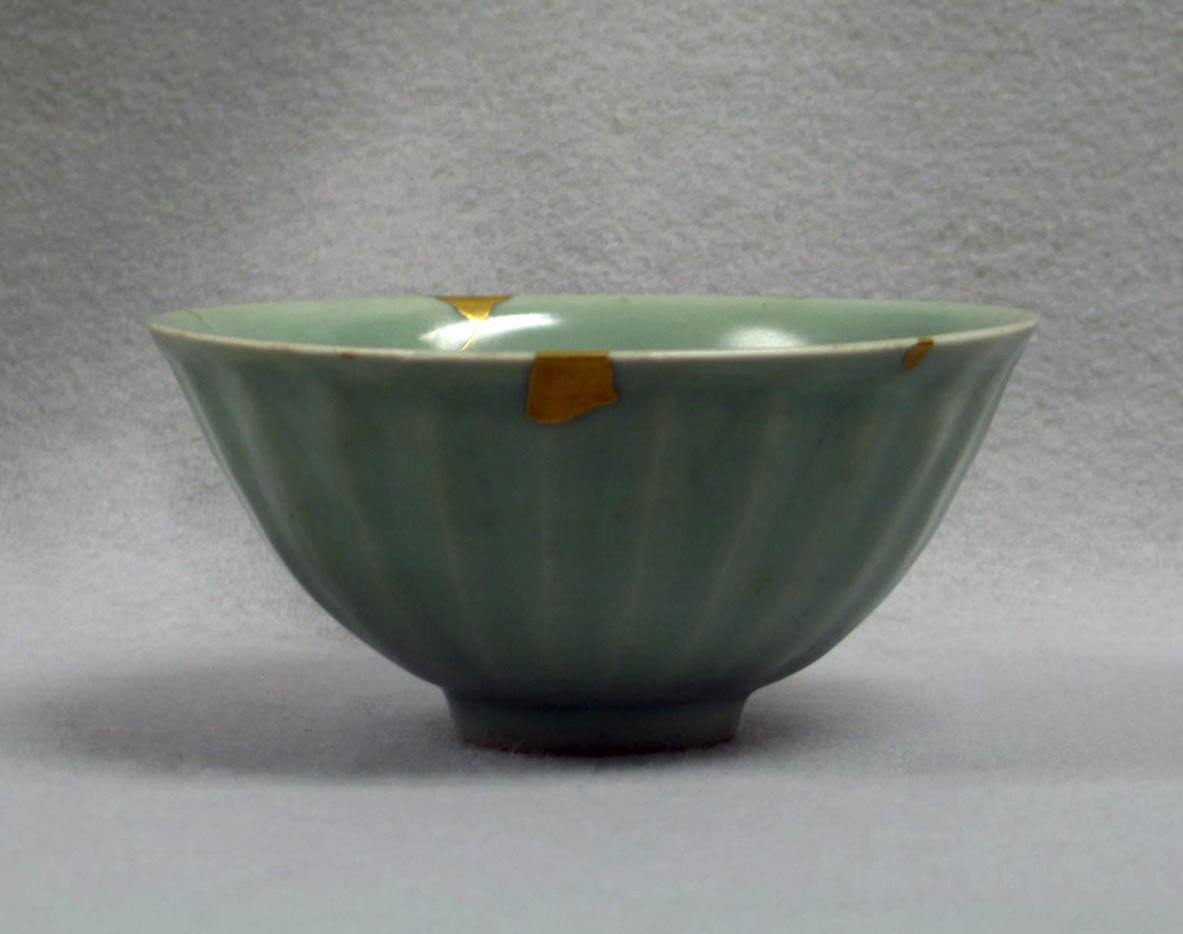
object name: bowl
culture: chinese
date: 1201-1300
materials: ceramic glaze, glaze, stoneware